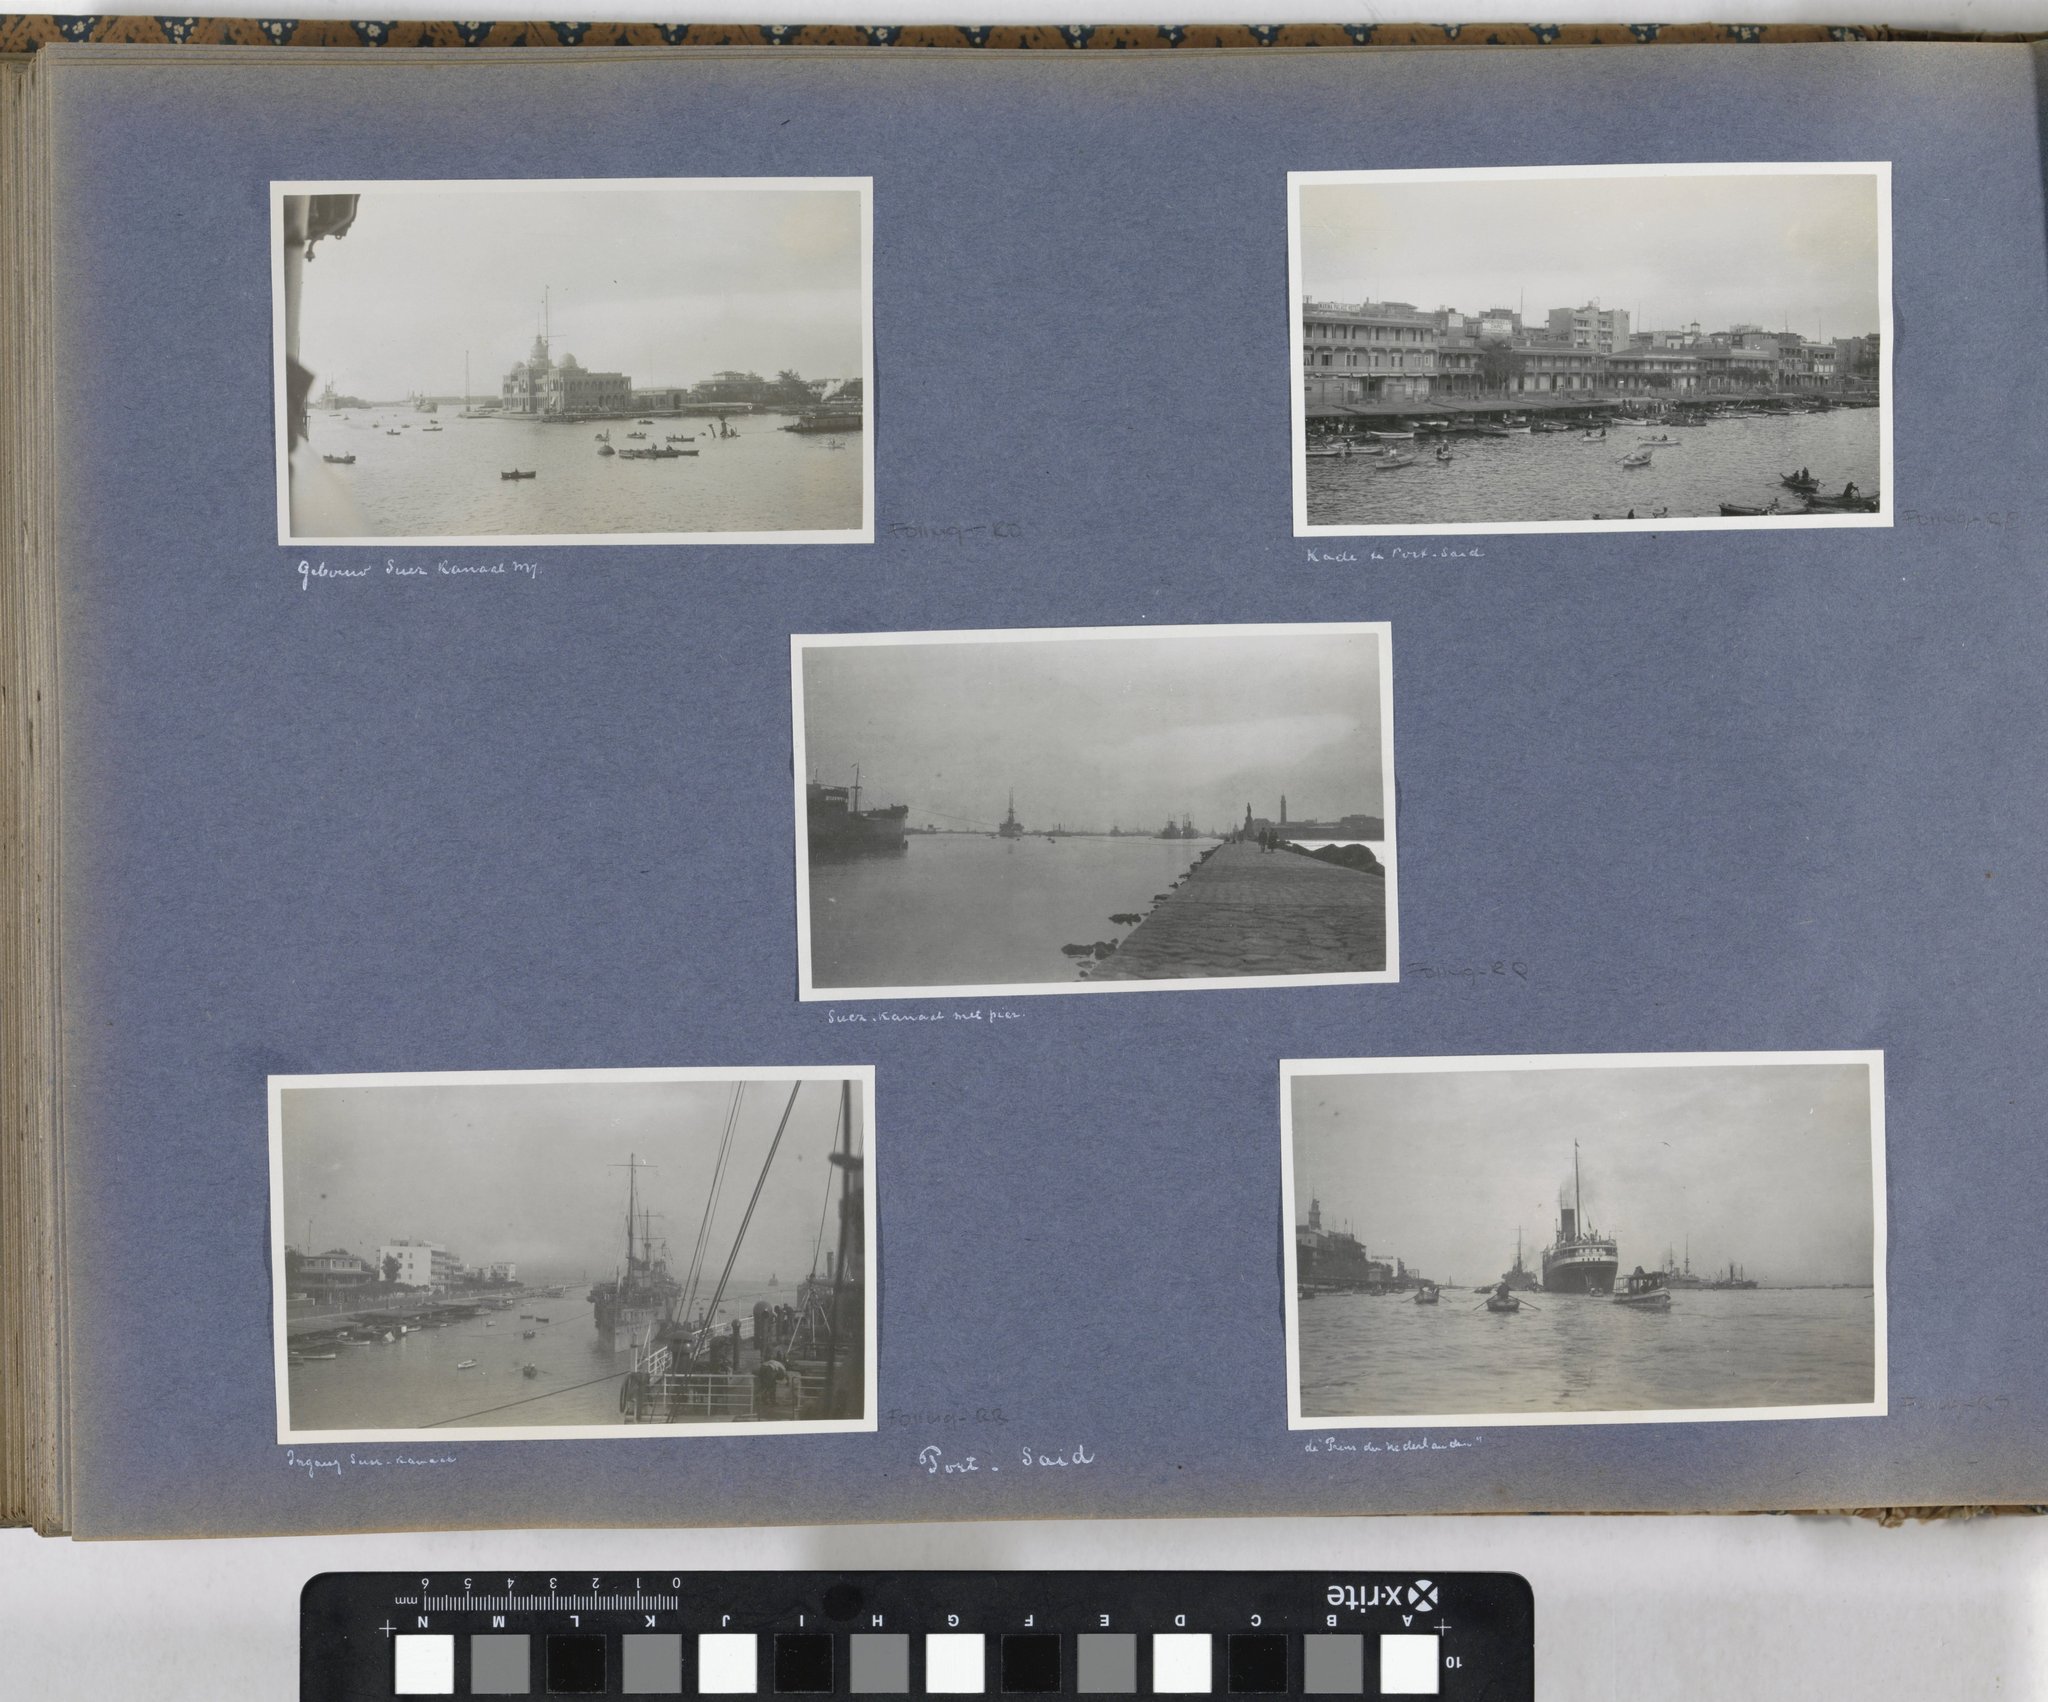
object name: album leaf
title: Schip 'Prins der Nederlanden' in Port Said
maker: Anonymous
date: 1900-1920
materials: paper, photographic support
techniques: gelatin silver print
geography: port said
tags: harbour (+ view ~ vehicle, ship, etc.), canal, steamship, motorship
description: Onderdeel van reisalbum met foto's van bedrijvigheid en bezienswaardigheden op Sumatra en Java en van de reis naar en van Nederlands-Indië.